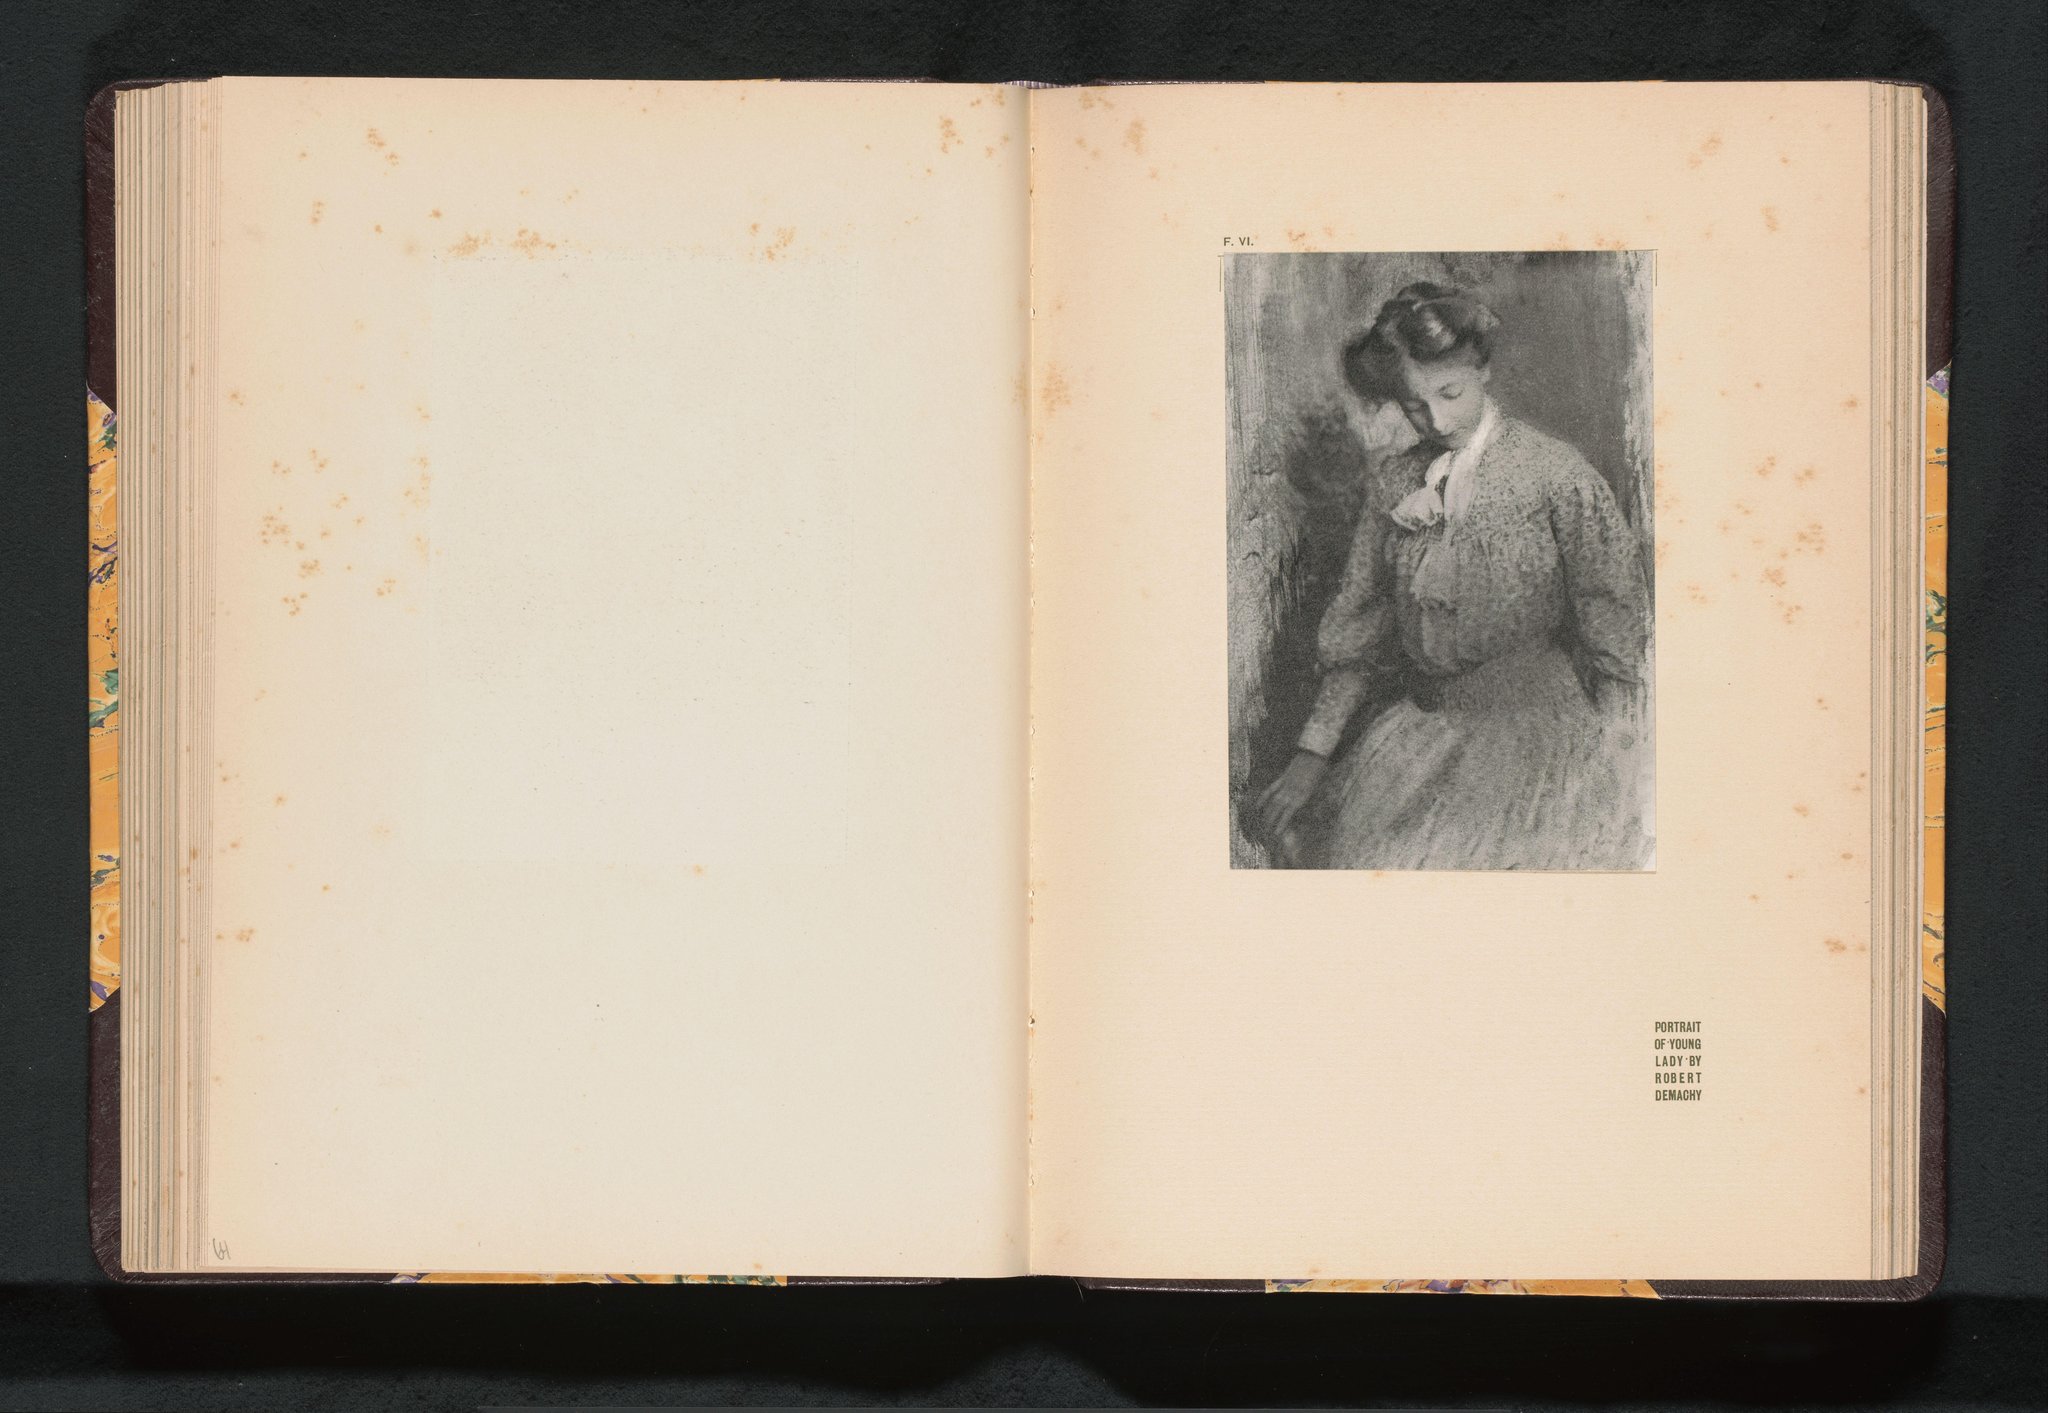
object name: photomechanical print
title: Portret van een onbekende jonge vrouw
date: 1900-1905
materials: paper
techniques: two-color autotype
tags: adolescent, young woman, maiden, historical persons - bb - woman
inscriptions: inscription: ‘Portrait of young lady by Robert Demachy’, inscription: ‘F. VI.’